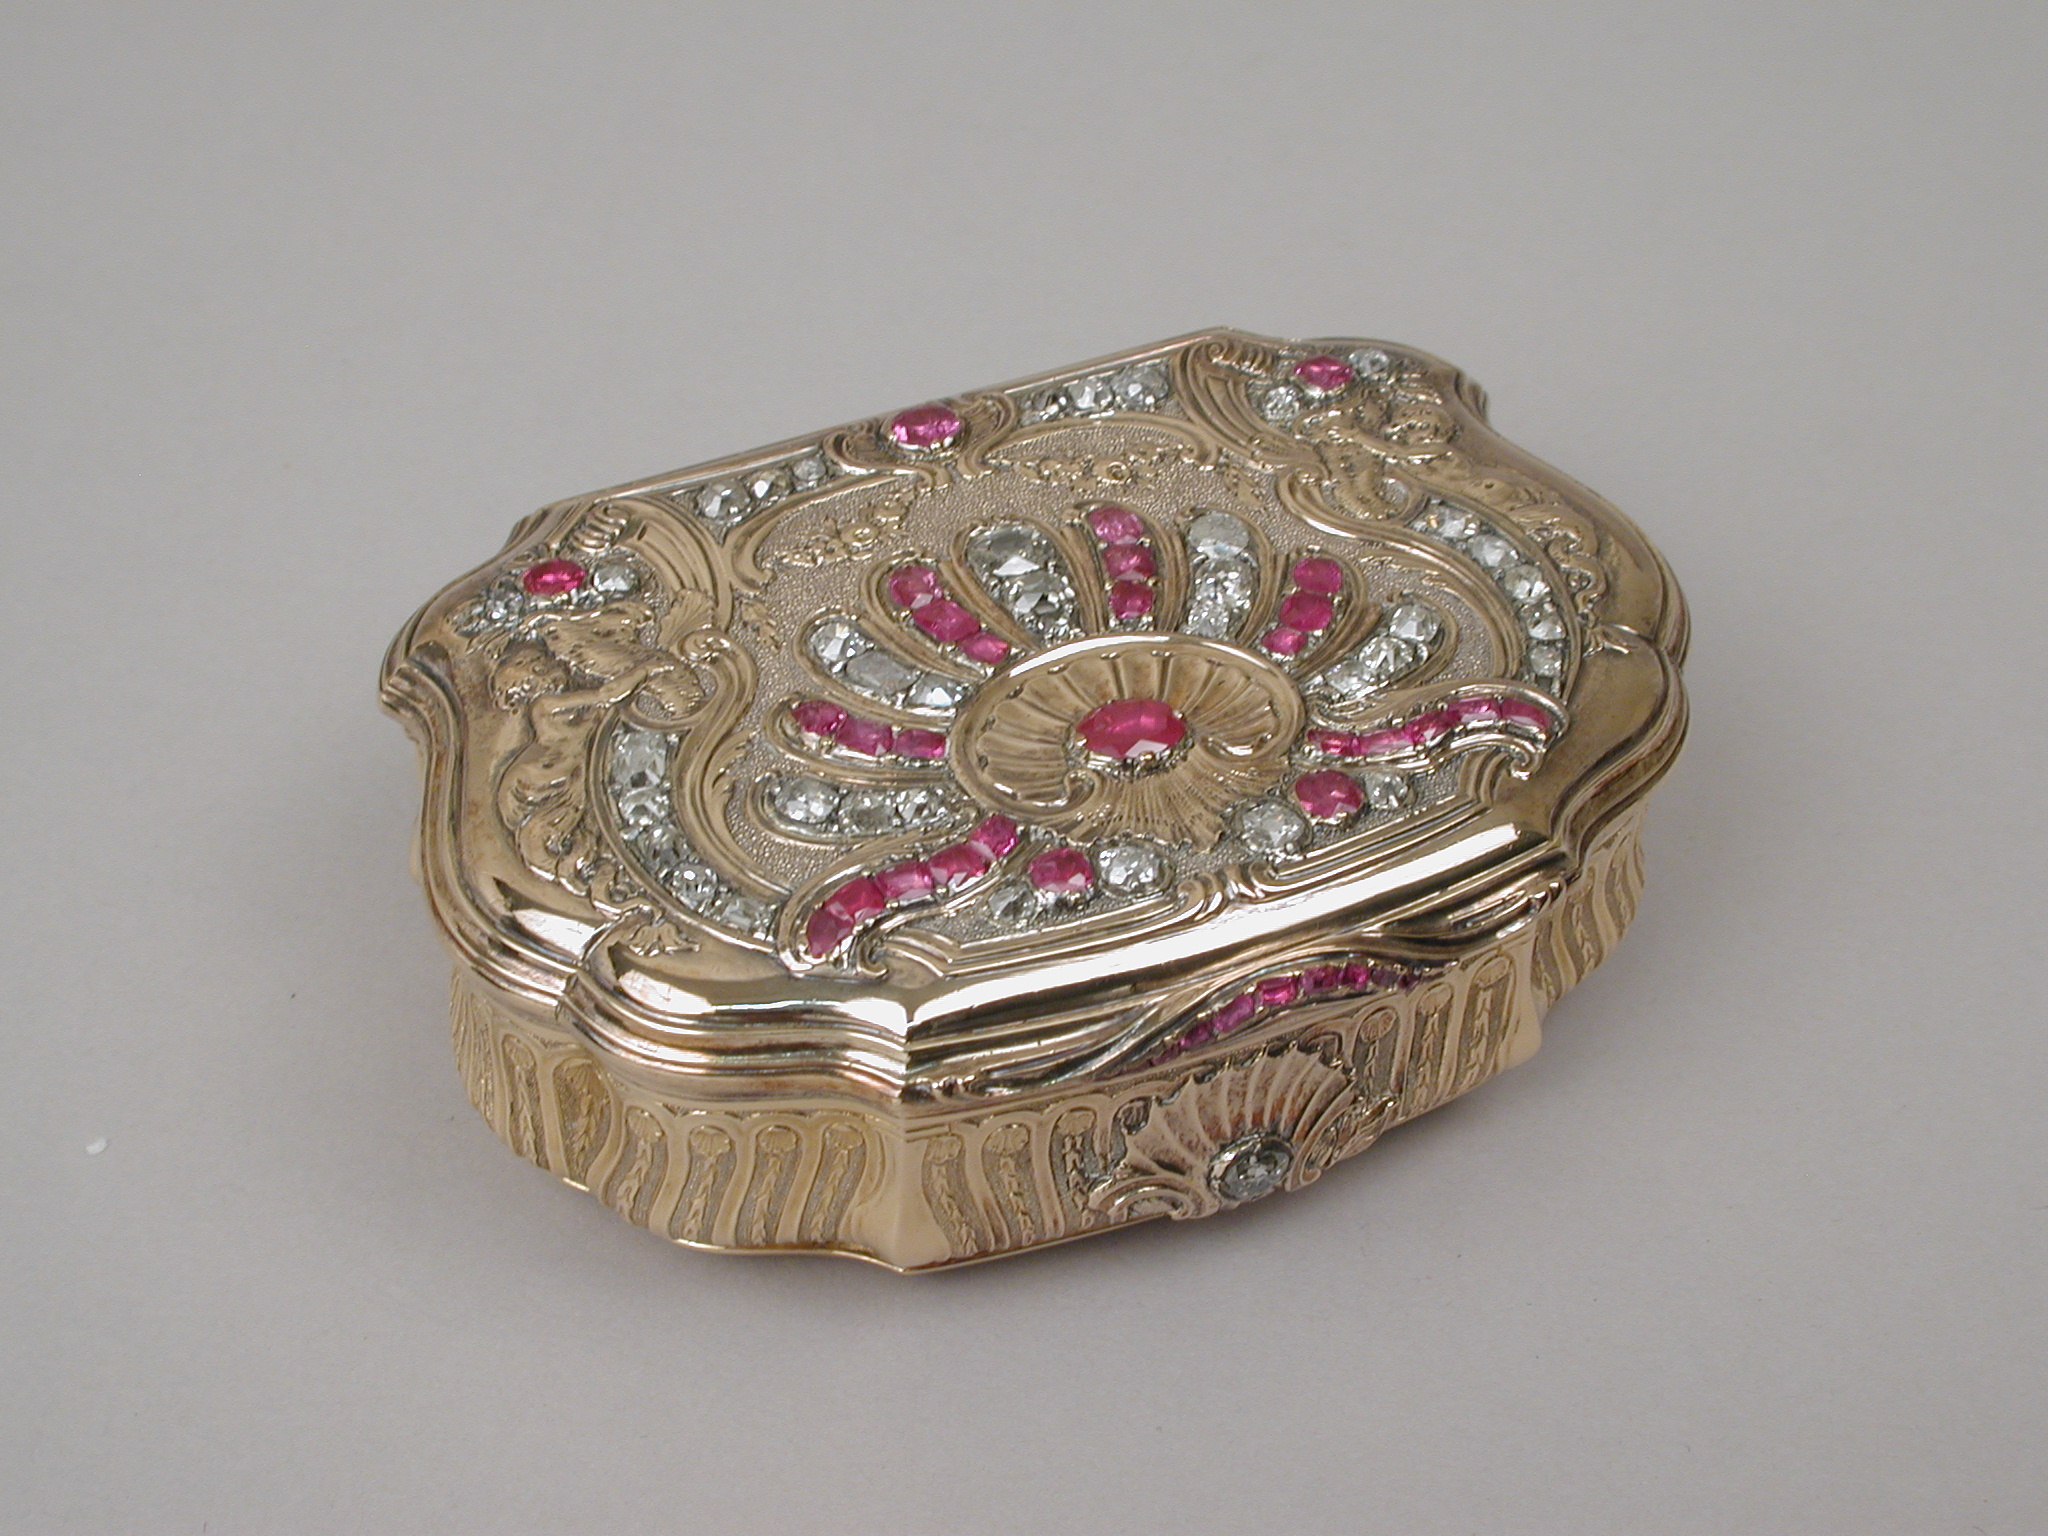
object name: snuffbox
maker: daniel govaers (or gouers)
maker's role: maker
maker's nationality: french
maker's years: 1681-1766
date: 1733-1734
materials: diamond, gold, gemstone